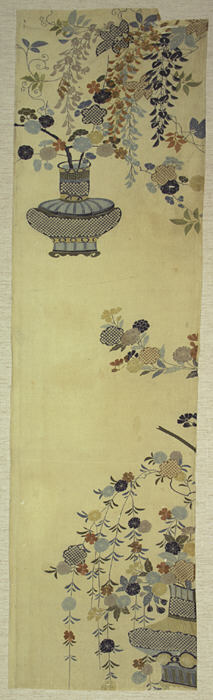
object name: piece from a kosode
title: Kosode Fragment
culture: japanese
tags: leaves